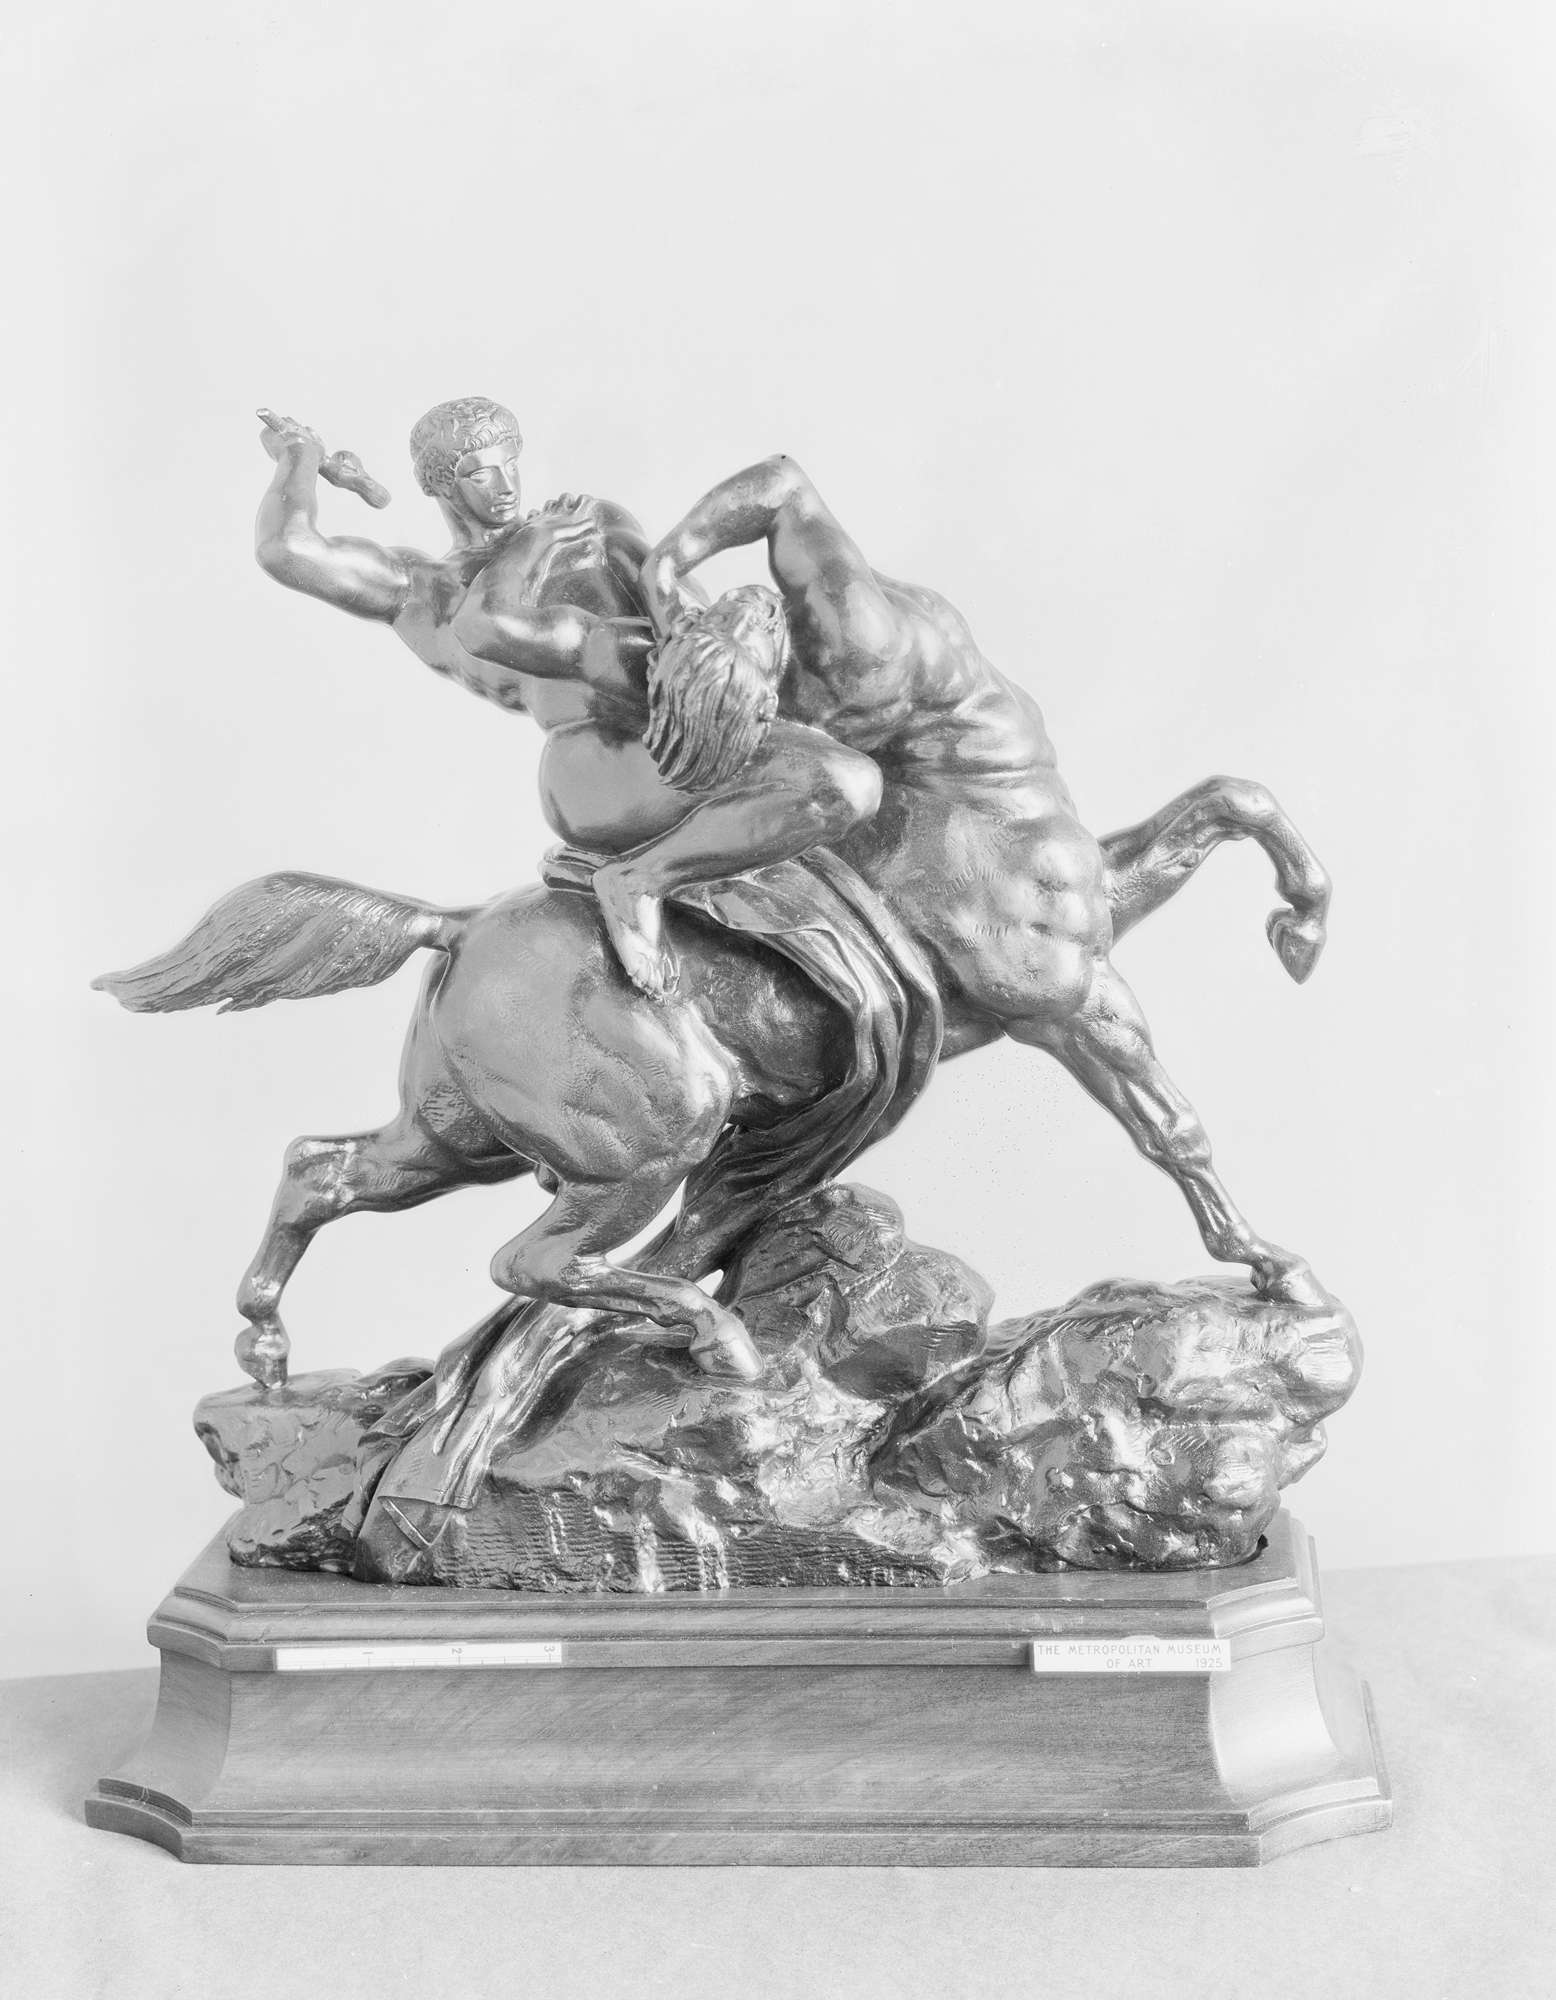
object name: statuette group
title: Theseus and the Centaur Bianor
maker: antoine-louis barye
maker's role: artist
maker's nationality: french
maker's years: 1795-1875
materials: bronze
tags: theseus,centaurs